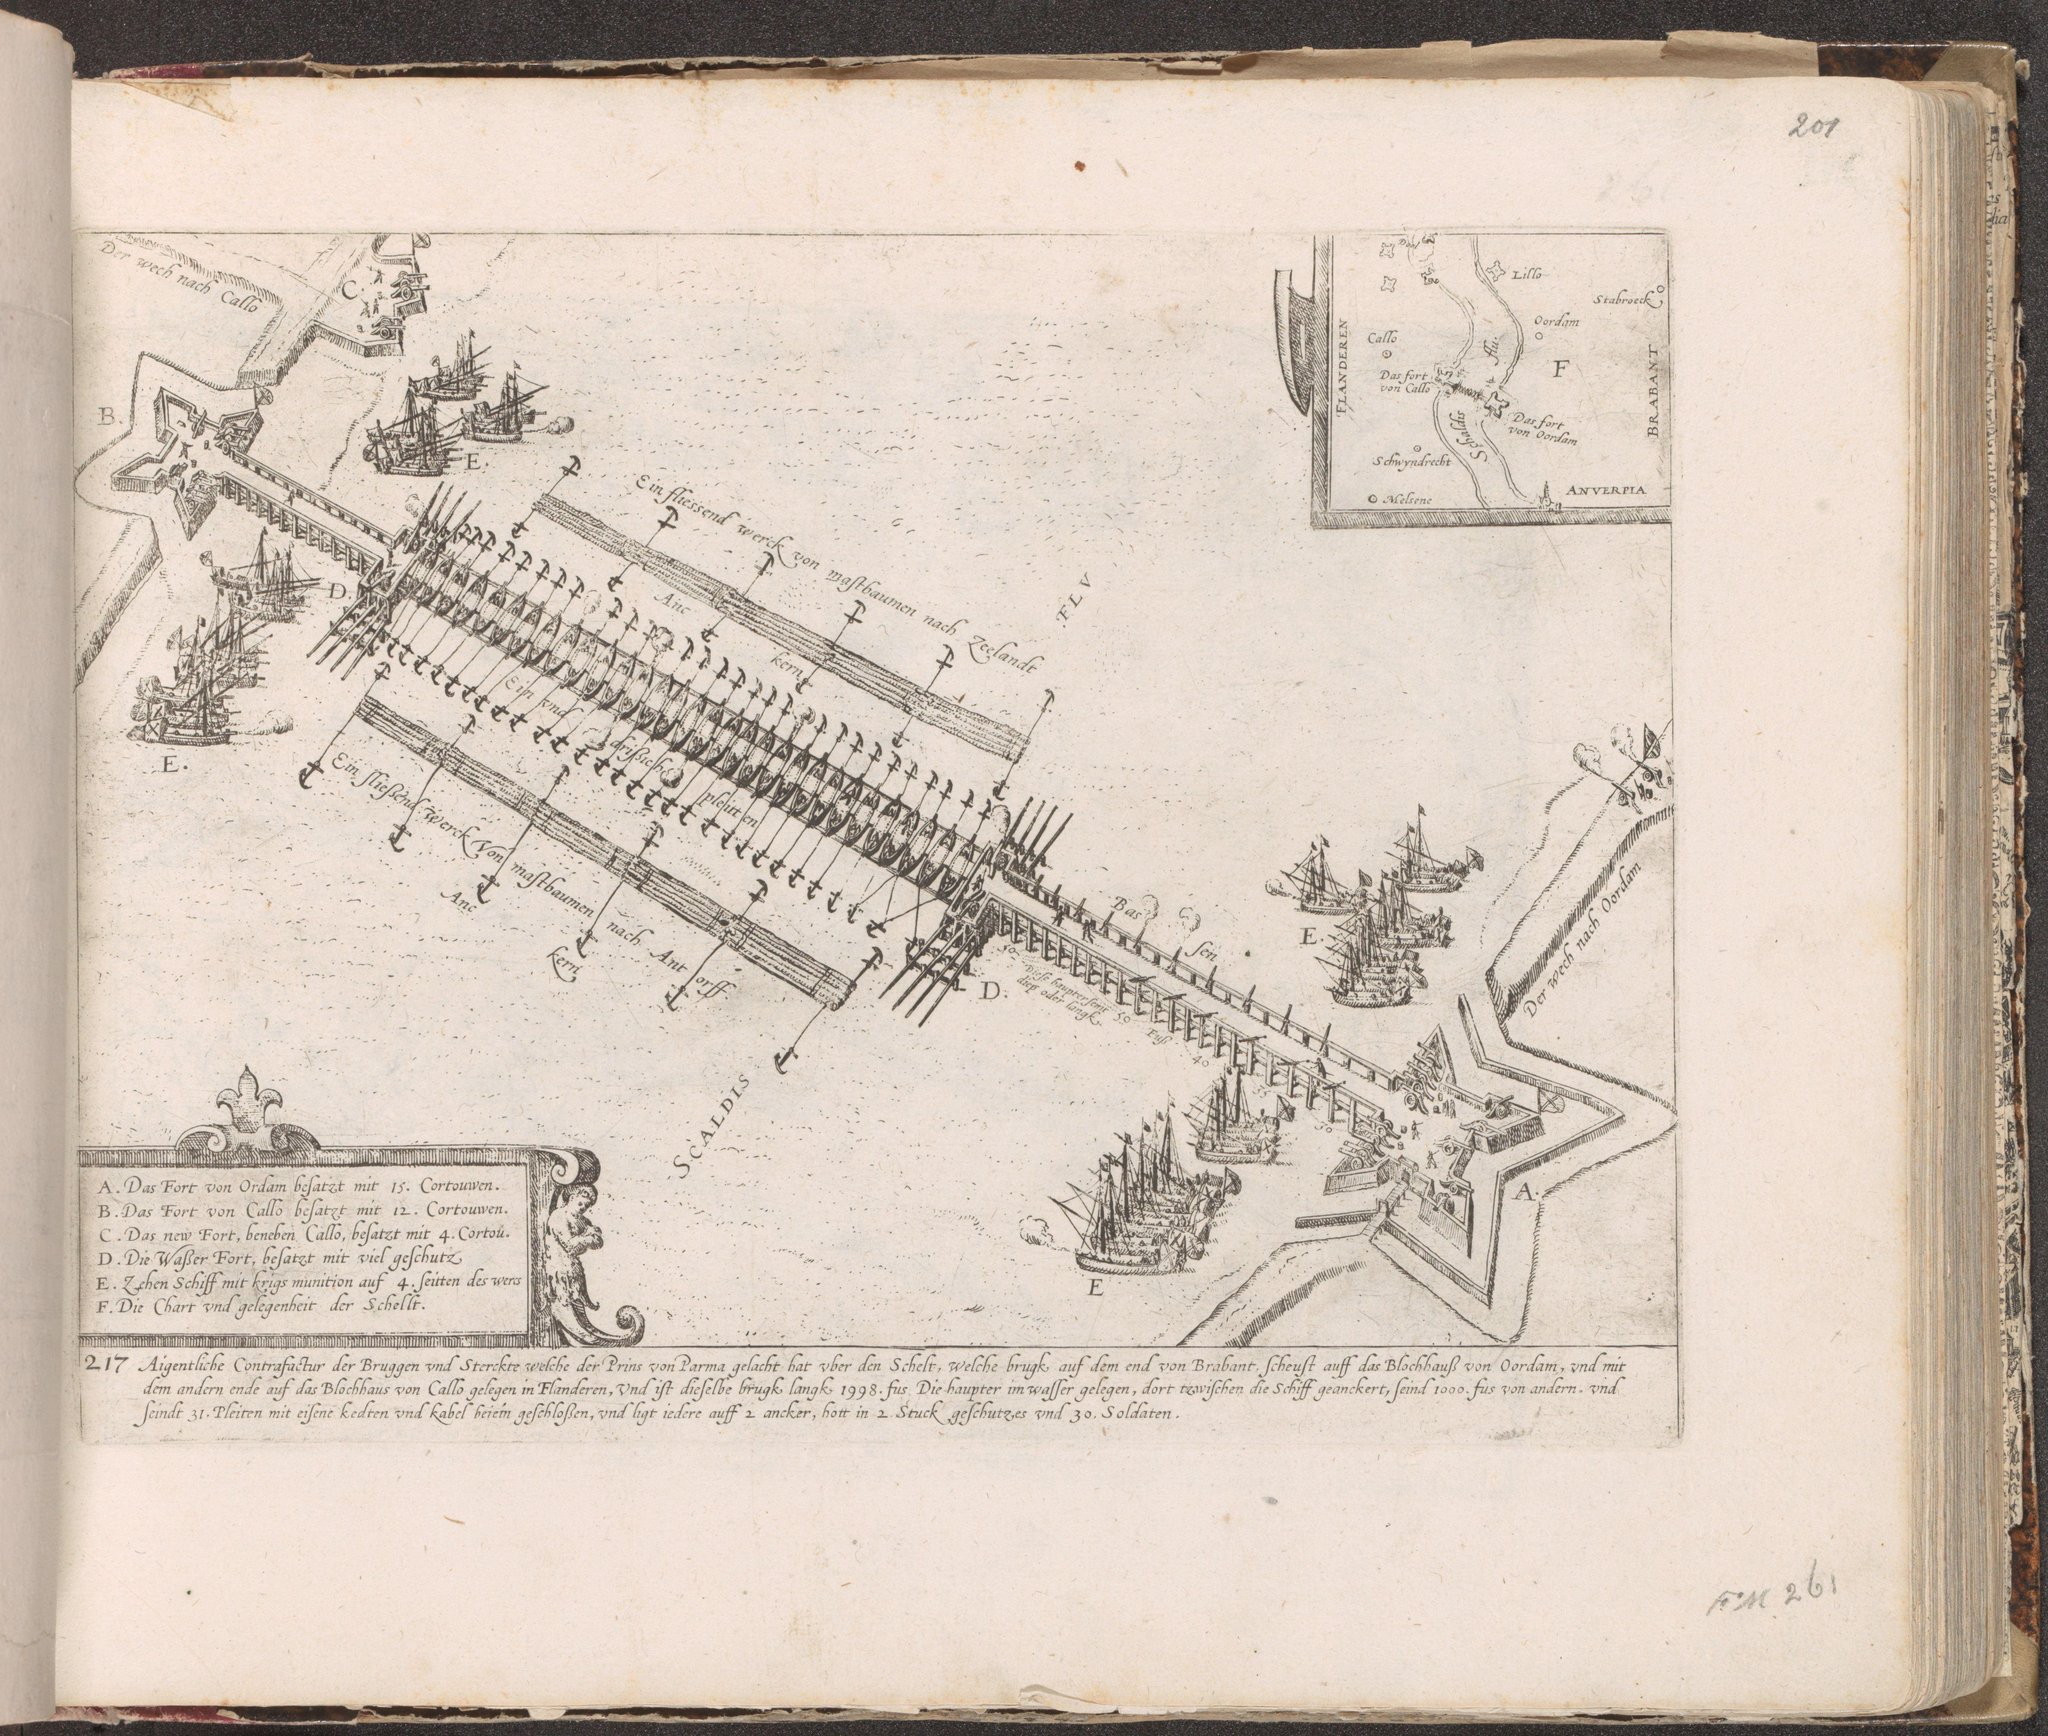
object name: history print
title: Serie 9: Nederlandse en Duitse Gebeurtenissen, 1583-1587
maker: frans hogenberg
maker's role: print maker, publisher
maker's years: 1538-1590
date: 1587-1591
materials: paper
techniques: etching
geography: cologne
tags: rome, alessandro farnese (landvoogd van de nederlanden en hertog van parma en piacenza), pontoon bridge, antwerp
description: Schipbrug gebouwd door het leger van de hertog van Parma waarmee de Schelde naar Antwerpen afgesloten werd. Voltooid op 24 februari 1584. Linksonder de legenda in een cartouche, rechtsboven een inzet met een kaartje van de regio. Met onderschrift van 3 regels in het Duits. Linksonder genummerd: 217. De prent maakt deel uit van een album.